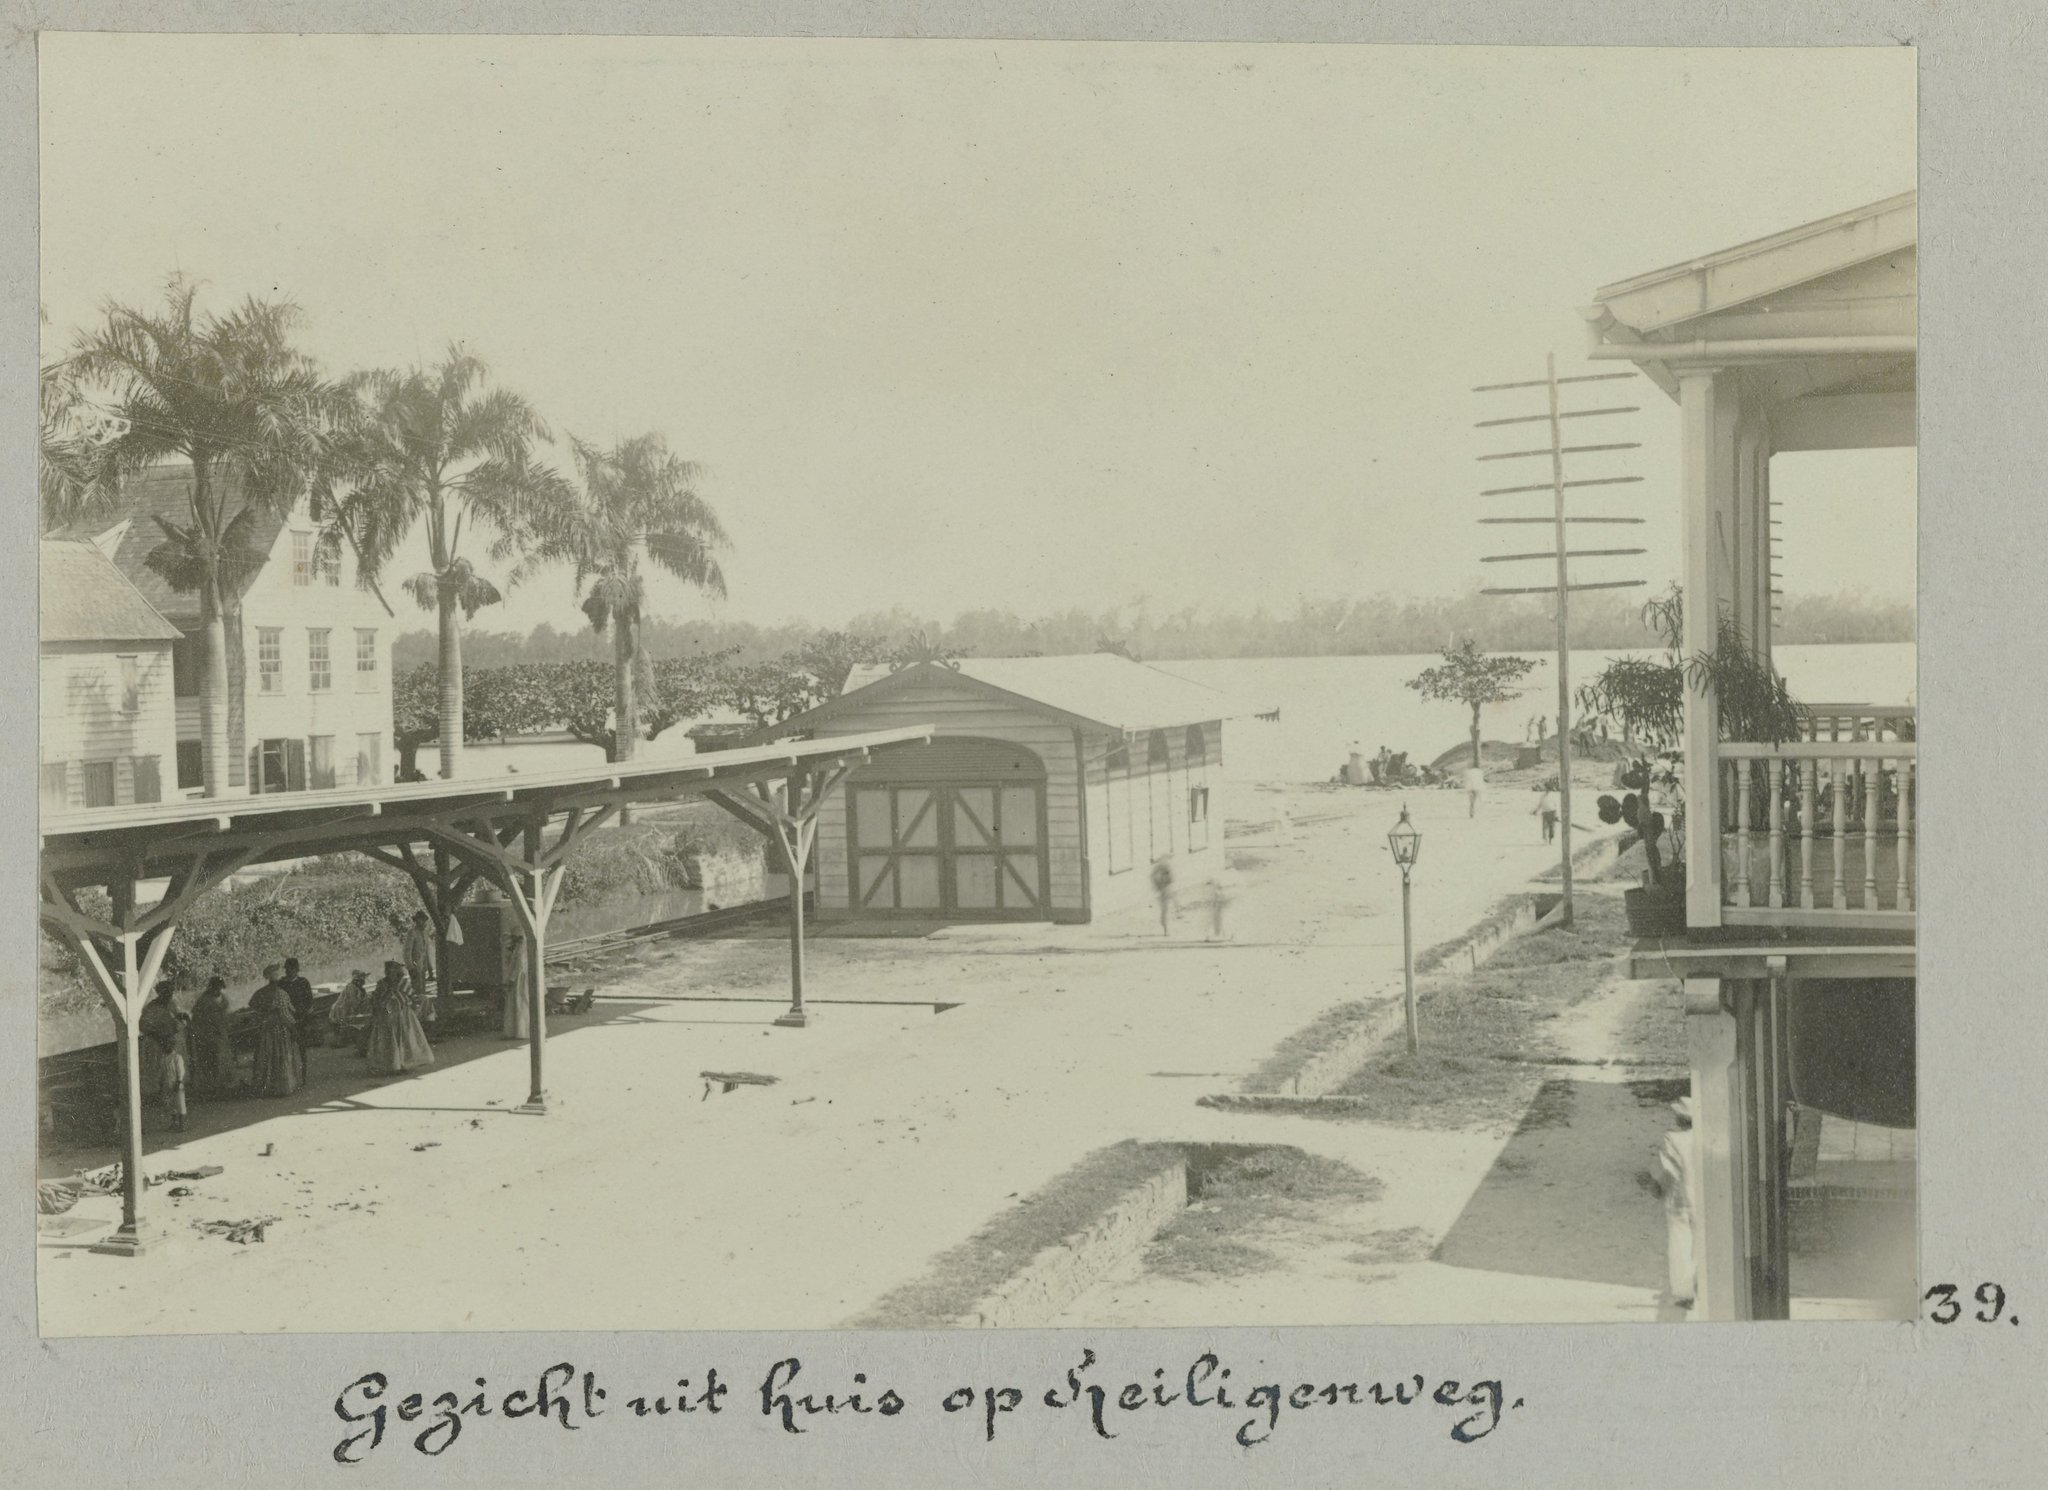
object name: photograph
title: Gezicht uit huis op Heiligenweg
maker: hendrik doijer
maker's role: engineer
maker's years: 1863-1925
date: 1903-1910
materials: photographic support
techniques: gelatin silver print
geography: suriname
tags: suriname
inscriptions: inscription: ‘39. / Gezicht uit huis op Heiligenweg.’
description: Gezicht op de Heiligenweg met overdekte passage, te Paramaribo. Onderdeel van het fotoalbum Souvenir de Voyage (deel 2), over het leven van de familie Doijer in en rond de plantage Ma Retraite in Suriname in de jaren 1903-1910.